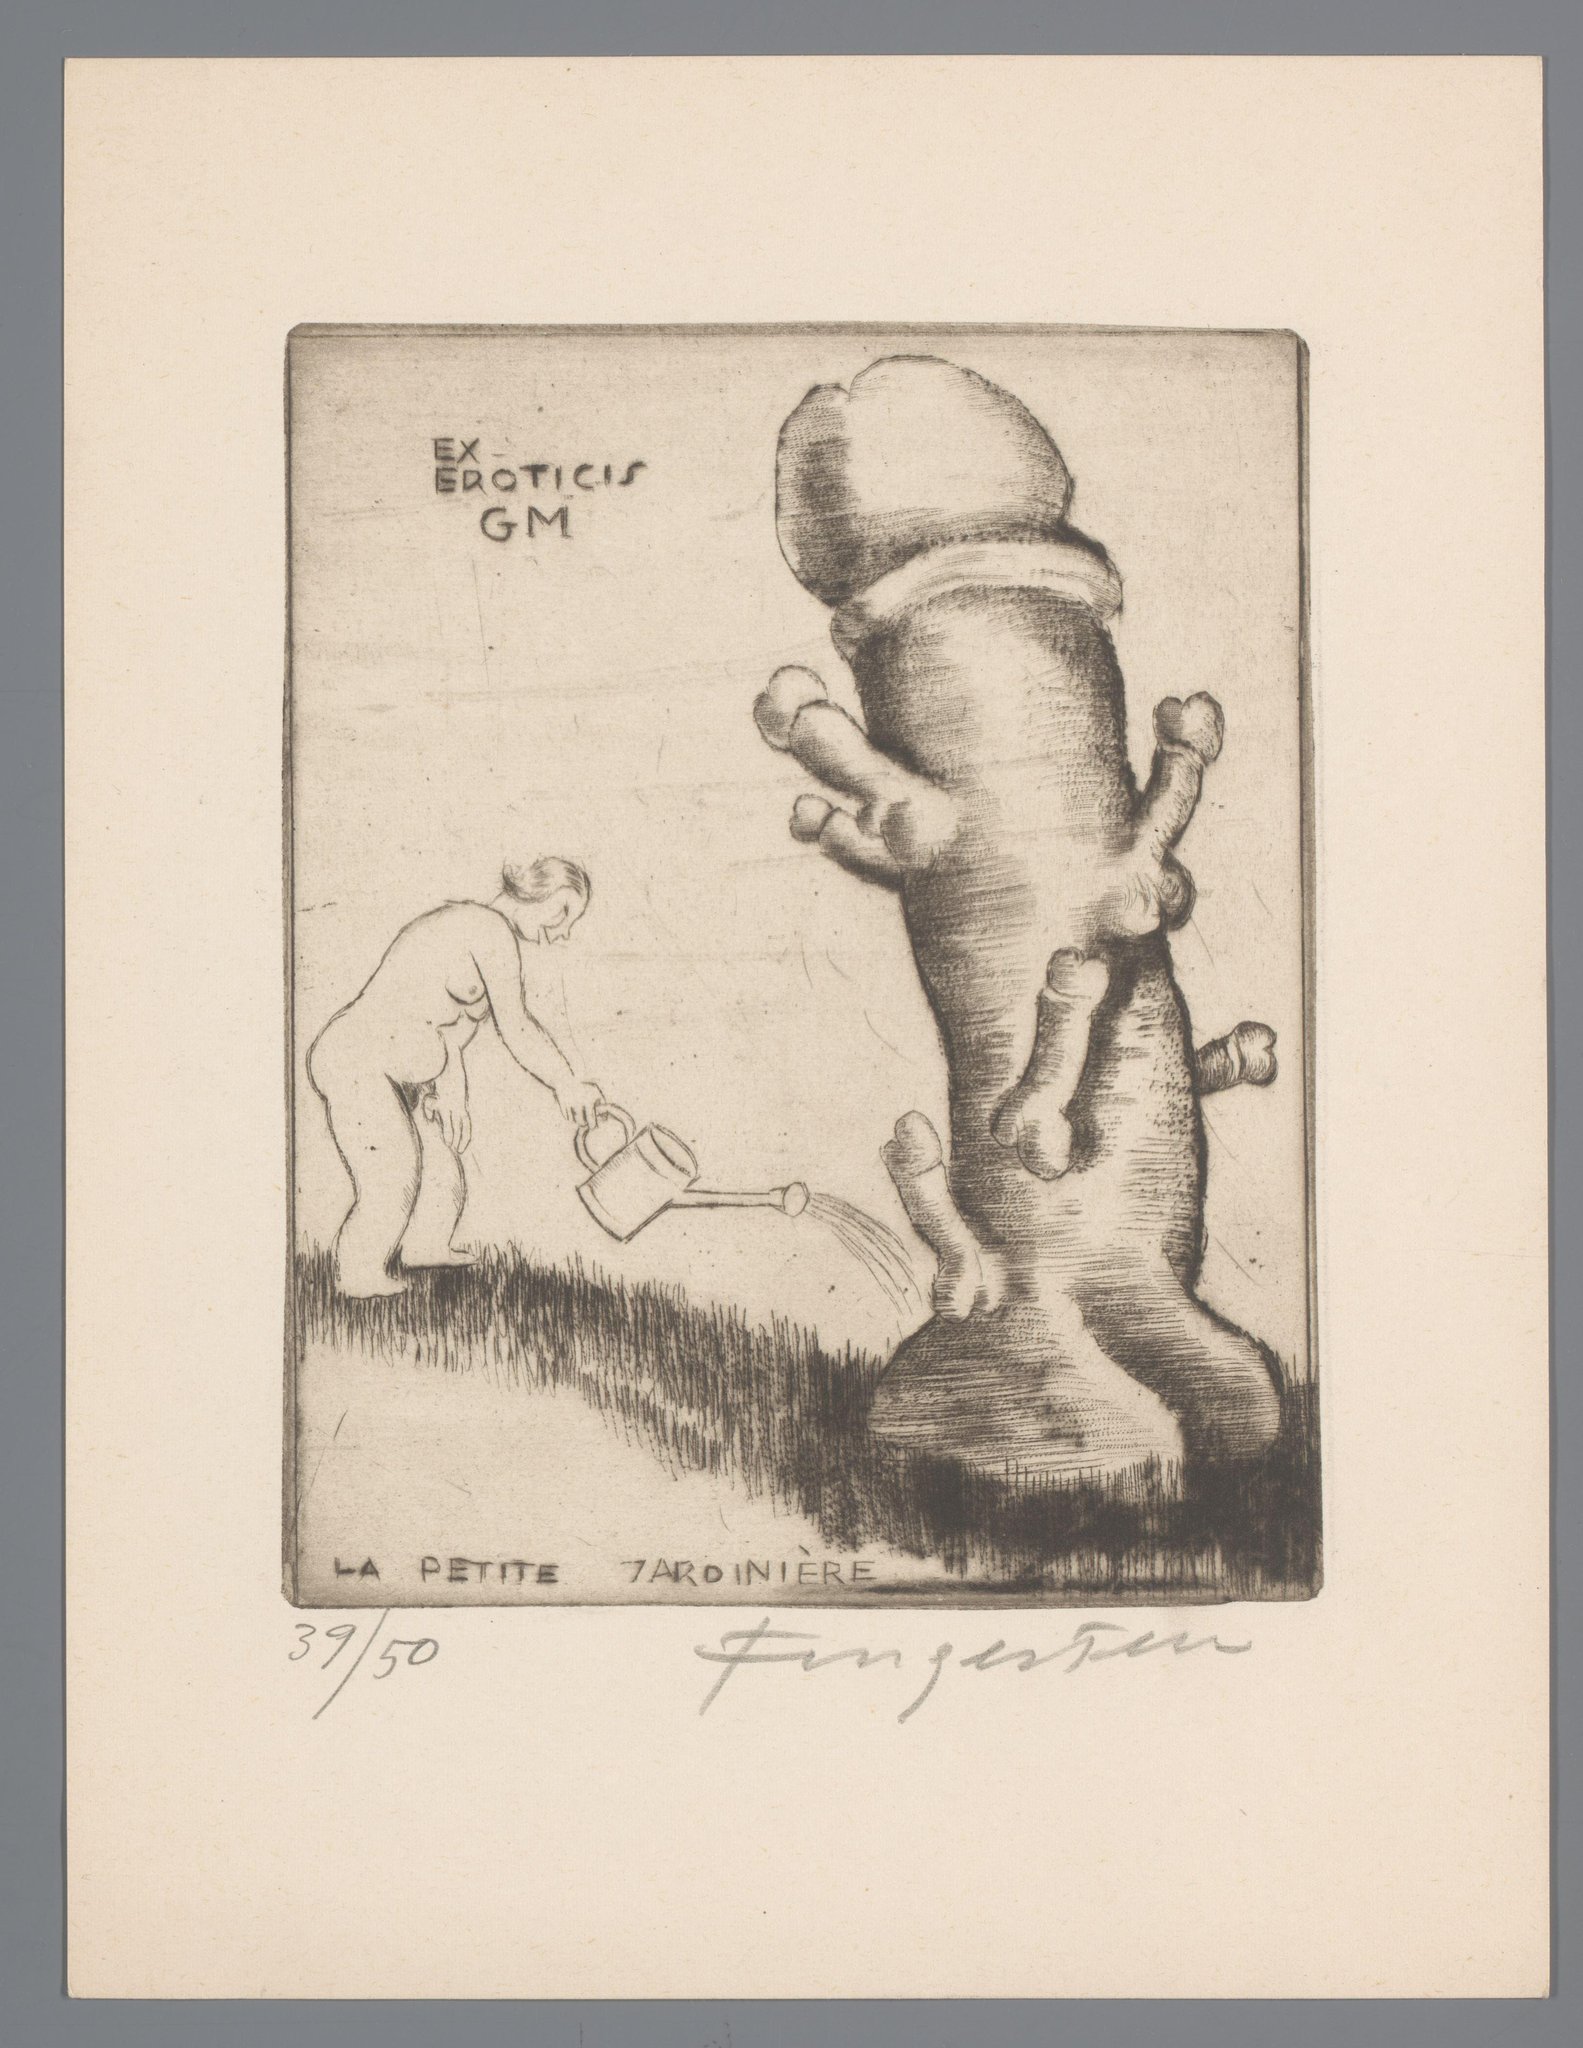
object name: bookplate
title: Ex eroticis GM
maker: michel fingesten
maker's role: painter, print maker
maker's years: 1884-1943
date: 1907-1943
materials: paper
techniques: drypoint, intaglio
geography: milan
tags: engineer, gianni mantero, woman (showing herself) undressed, quasi-nude, penis, phallus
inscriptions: signature: ‘39/50 Fingesten’